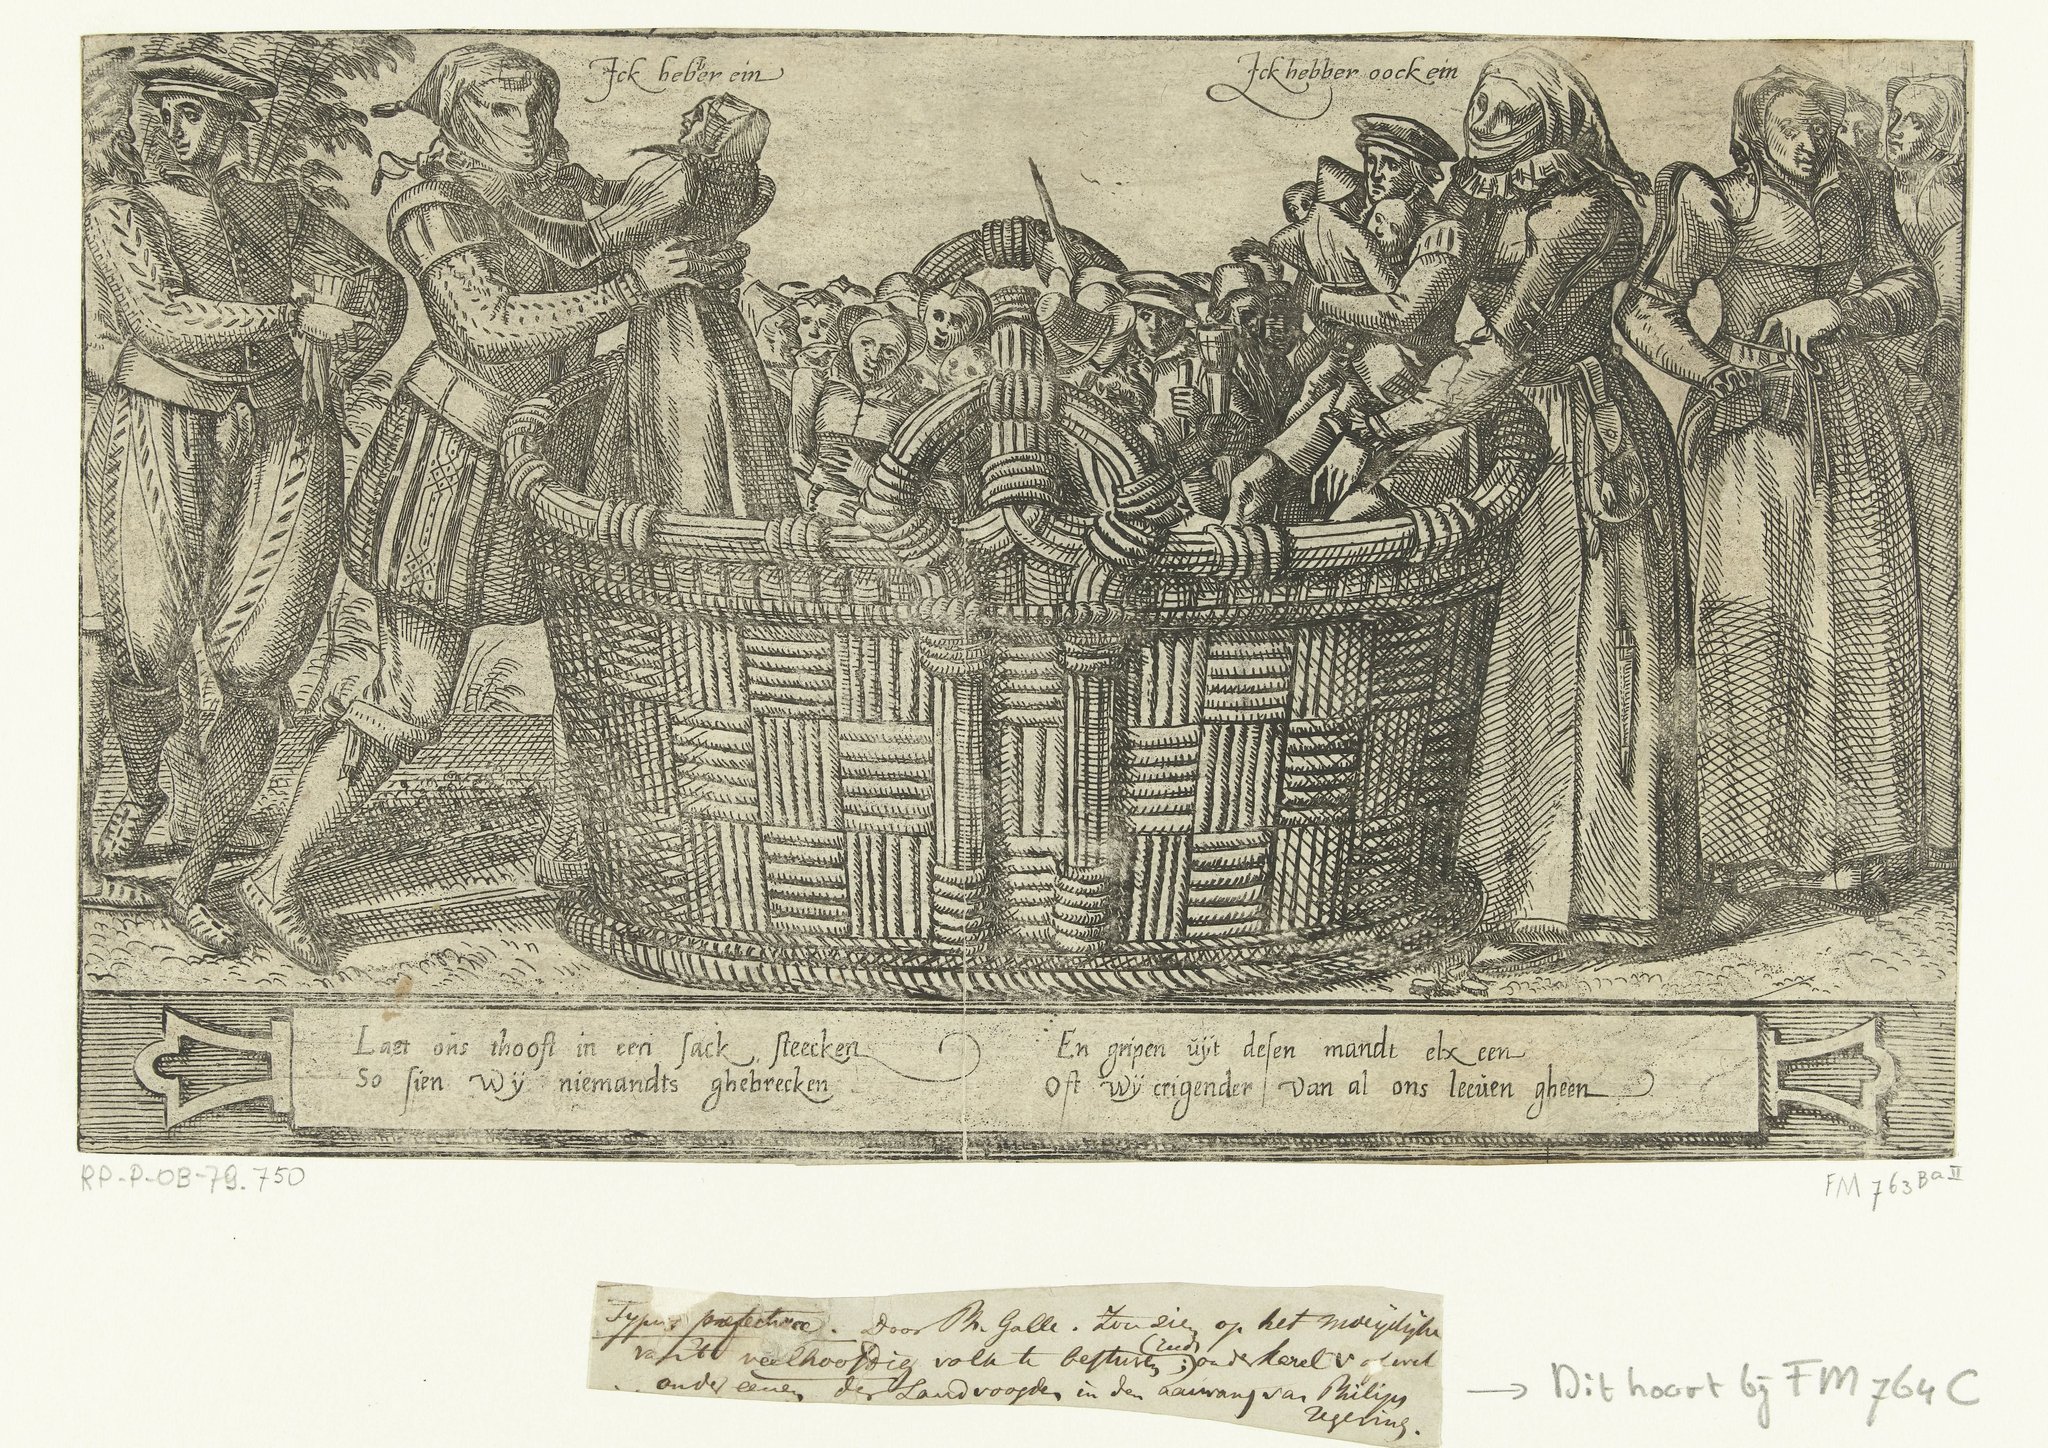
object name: print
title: Spotprent op de gebreken van alle mannen en vrouwen, ca. 1577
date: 1575-1579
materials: paper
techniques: etching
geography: low countries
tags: antwerp, painter, draughtsman, peeter baltens, container made of plant material other than wood: basket, satire on marriage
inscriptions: inscription: ‘Dit Pack zalmen geven aen Pieter Baltens schilder woonende tegen over de Wilde Zee in de Corte Gasthuysstrate tot Antwerpen - Den Bode zyn loon’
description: Spotprent op het huwelijk, op de gebreken van alle mannen en vrouwen, ca. 1577. Uit een grote mand trekken een geblinddoekte man en vrouw een partner. Met onderschrift van 4 regels in het Nederlands.